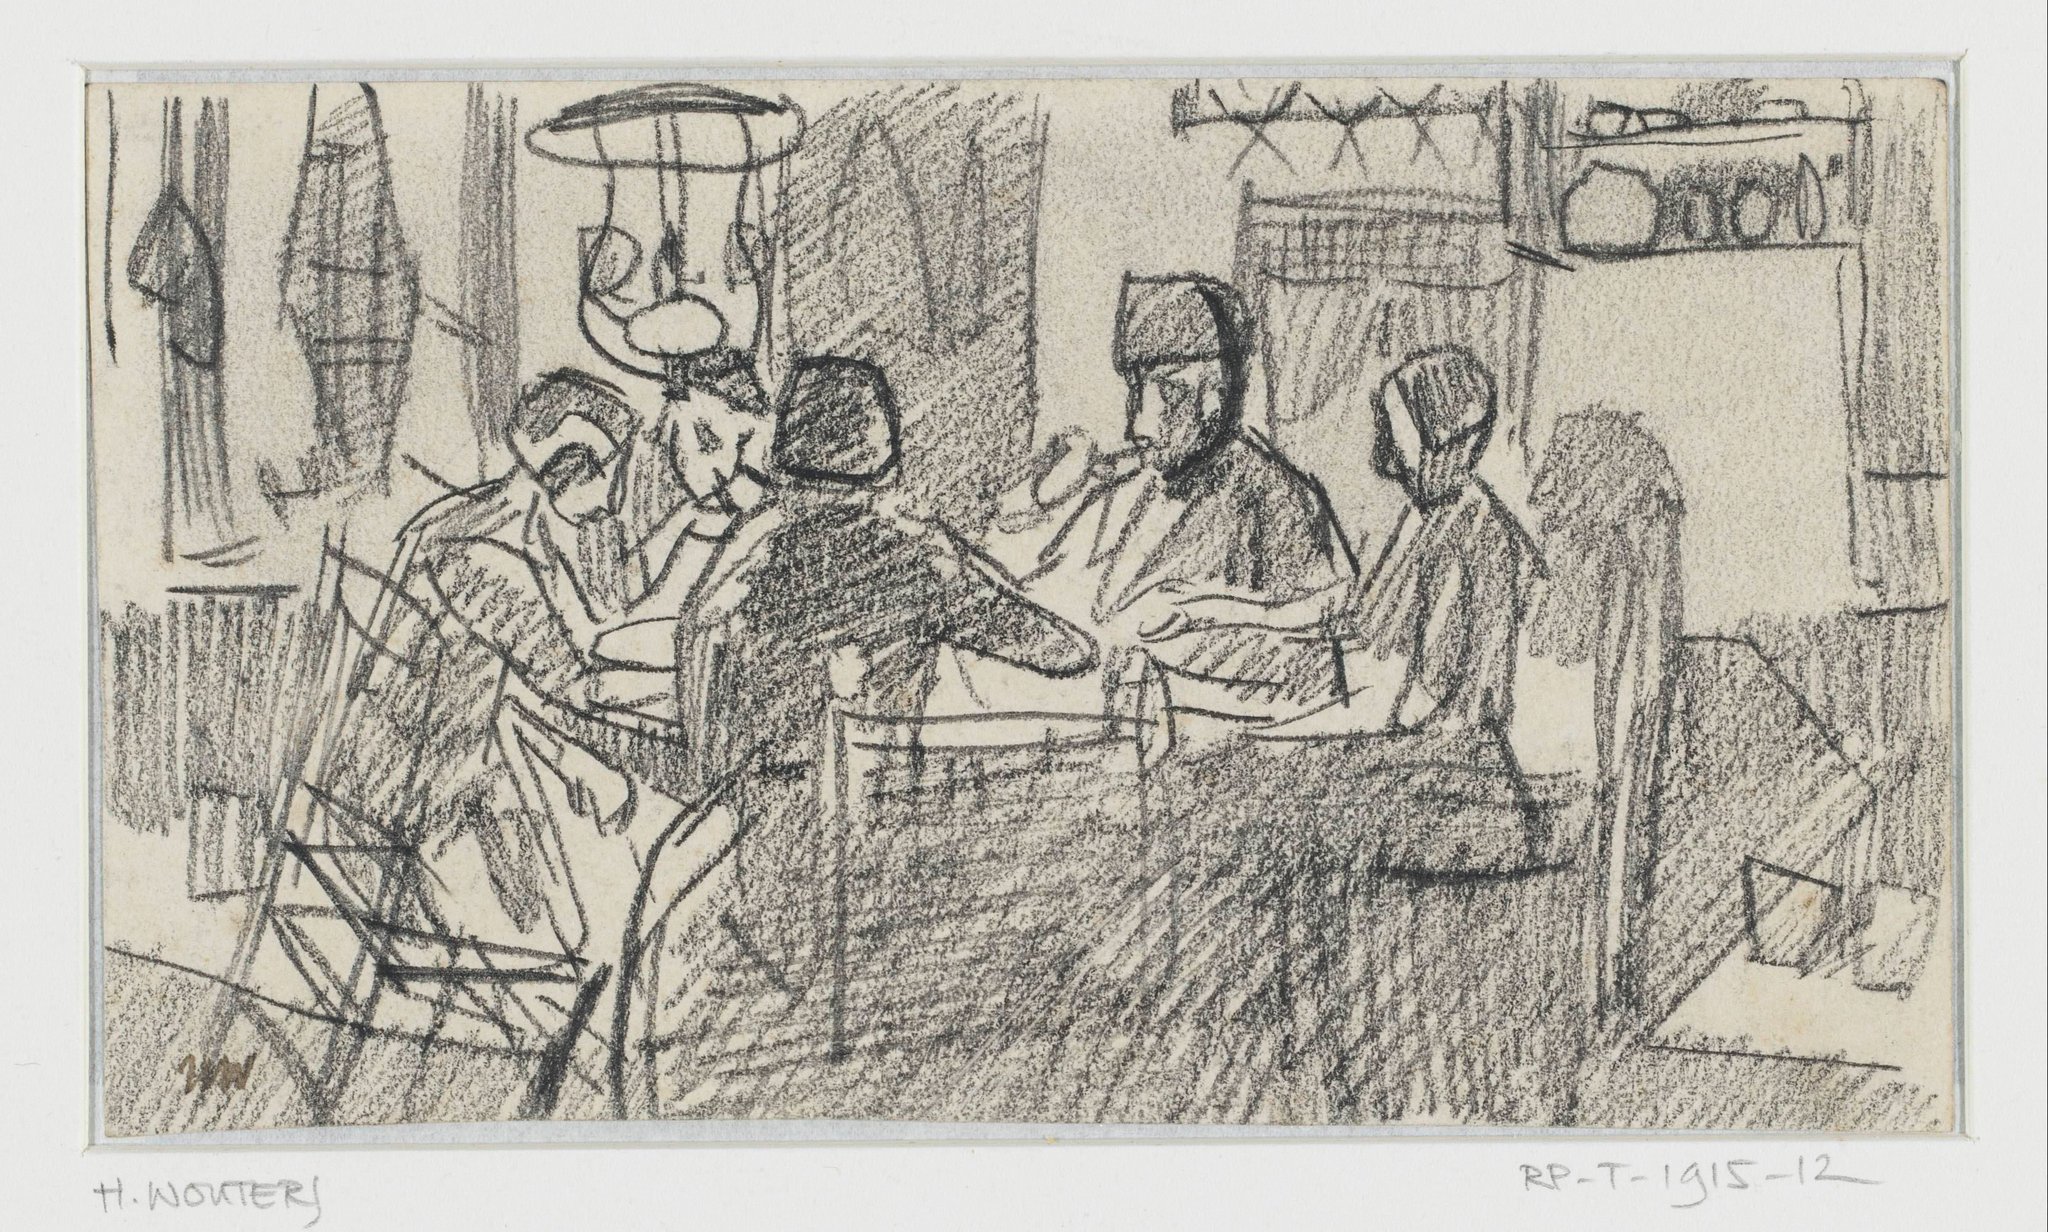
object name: drawing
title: Boereninterieur met vijf mensen aan tafel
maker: henri wouters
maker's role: draughtsman, print maker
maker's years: 1866-1935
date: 1876-1915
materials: chalk, paper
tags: interior of the house, farm (building), eating